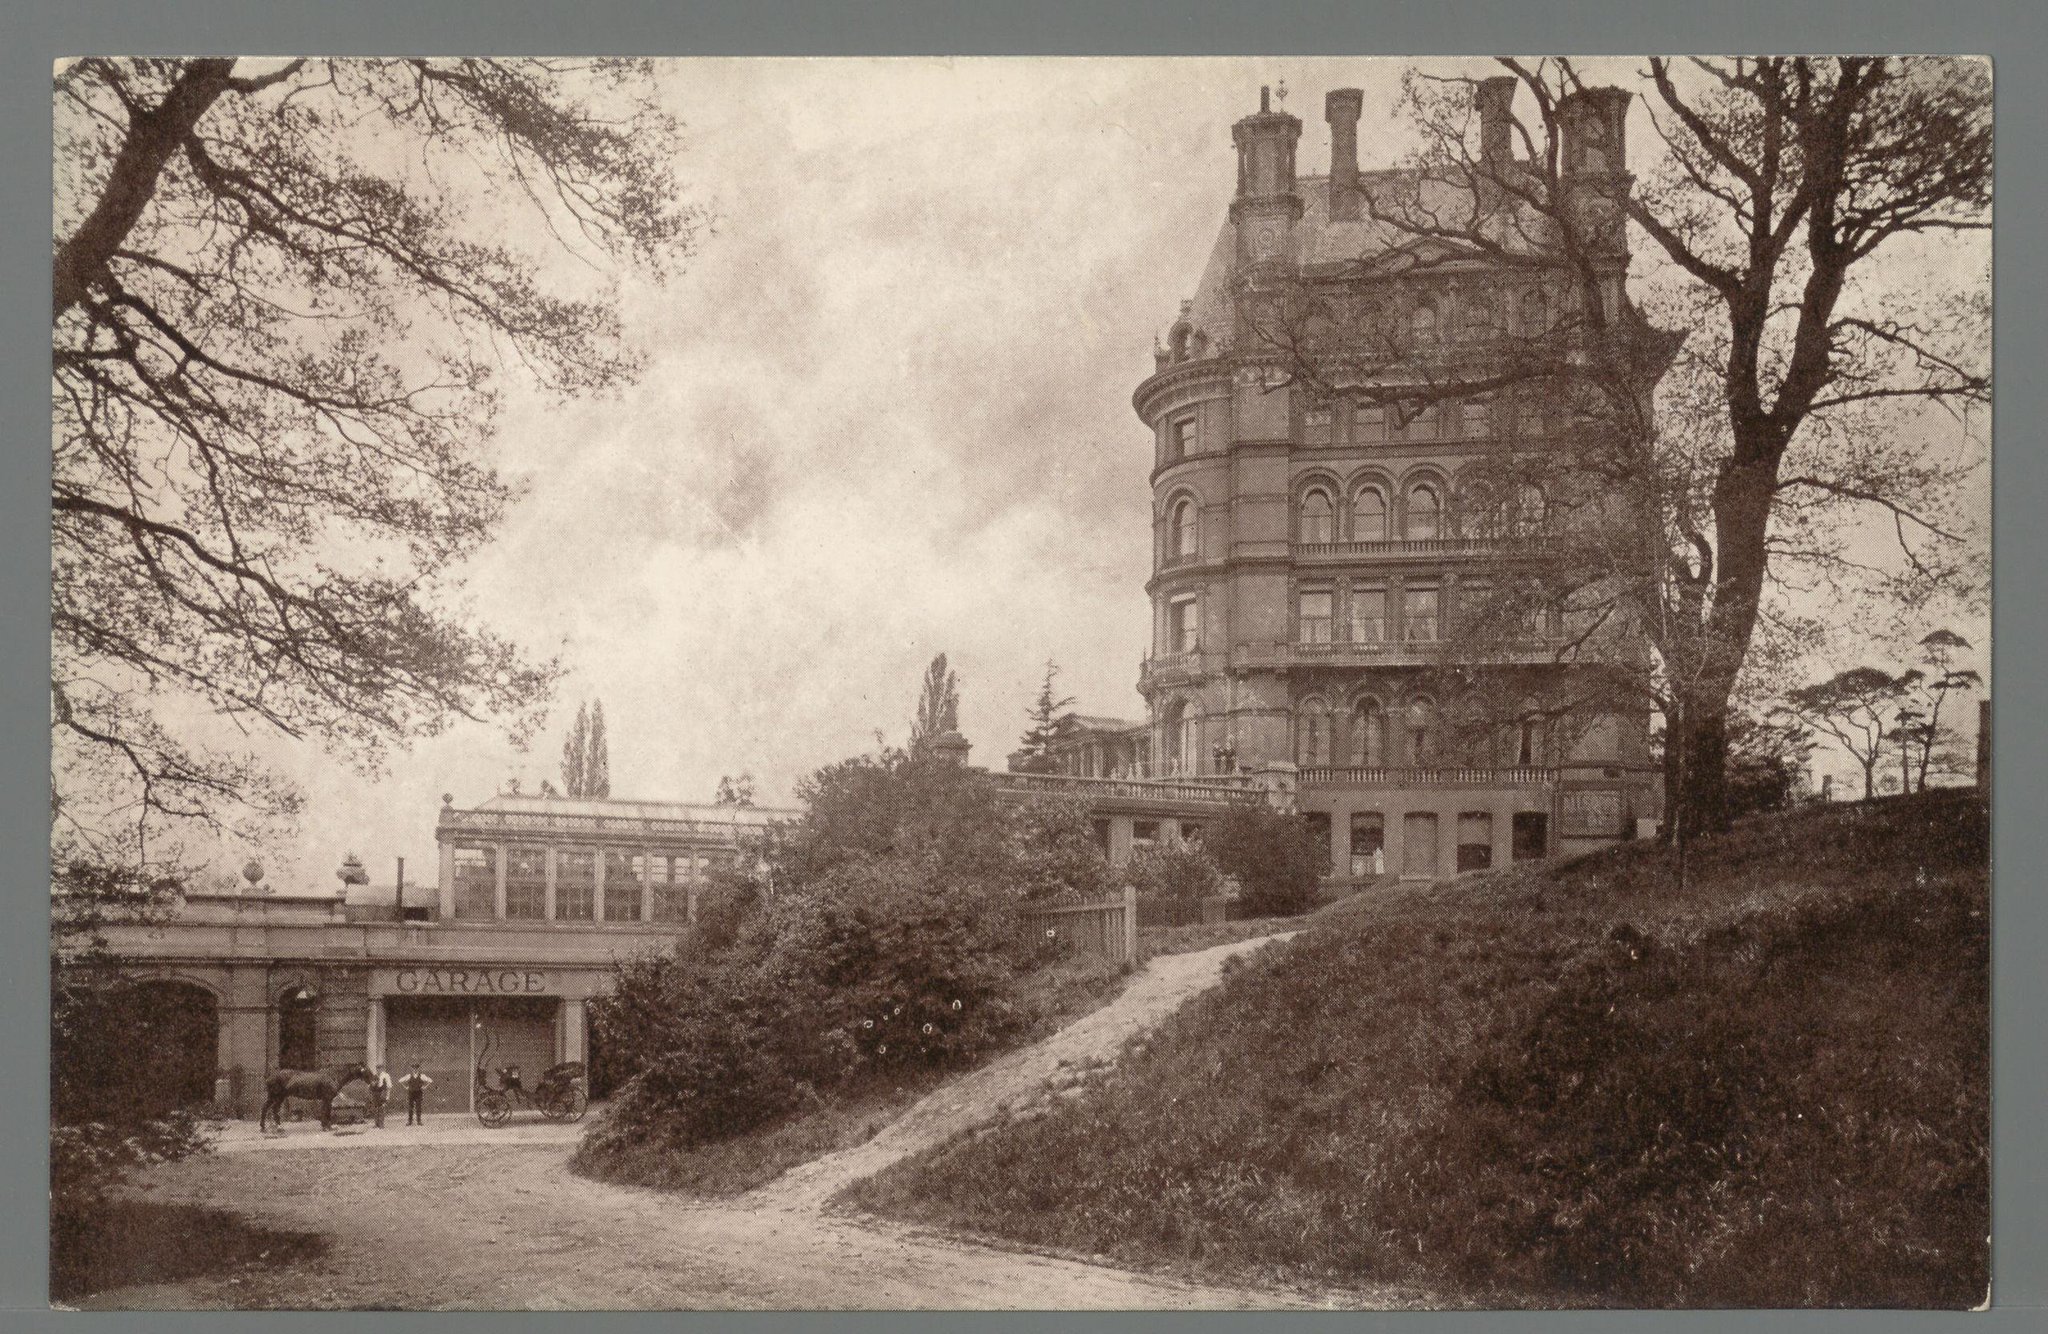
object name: photomechanical print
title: View from "Petersham Wood"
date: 1902-1930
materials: cardboard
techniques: autotype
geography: england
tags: garage, hotel, hostelry, inn